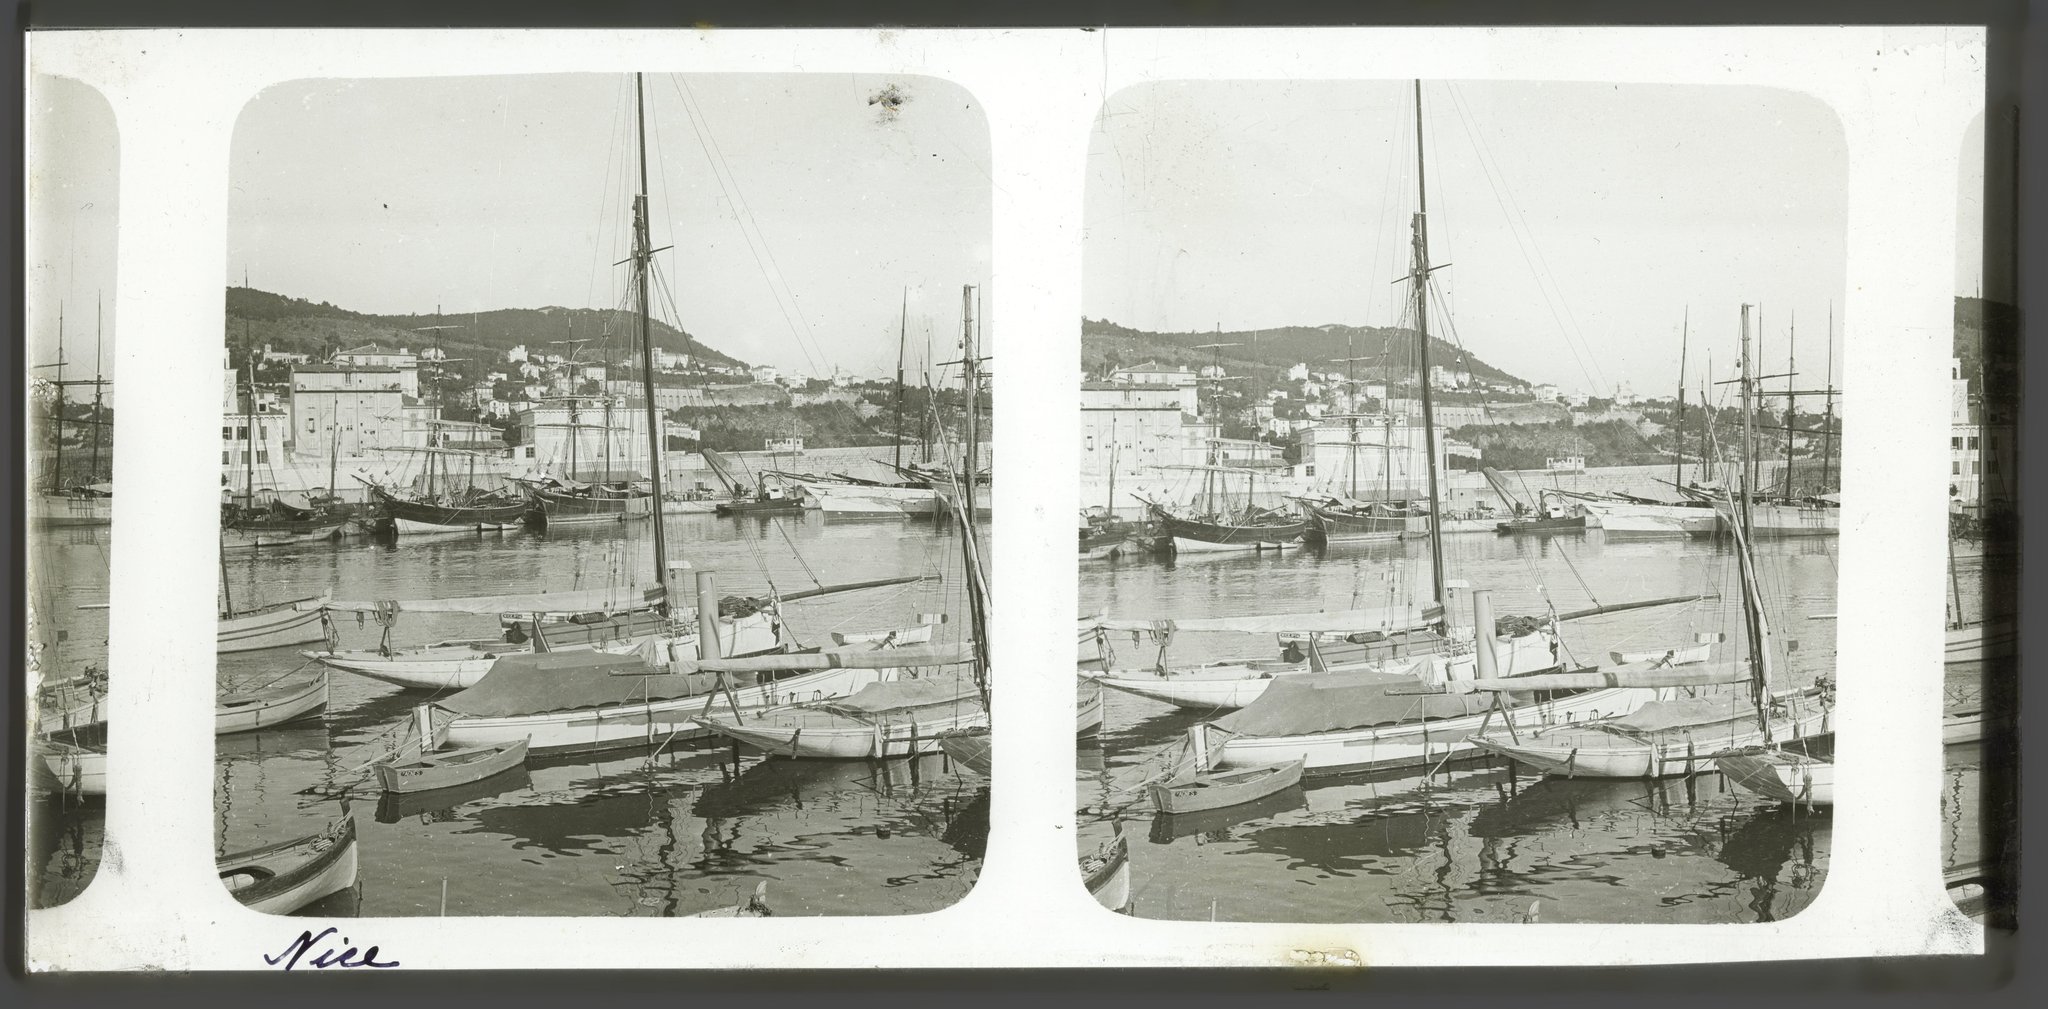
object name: stereoscopic photograph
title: Boten in de haven van Nice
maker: Anonymous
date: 1880-1900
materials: glass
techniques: slide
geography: nice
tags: harbour, sailing-ship, sailing-boat